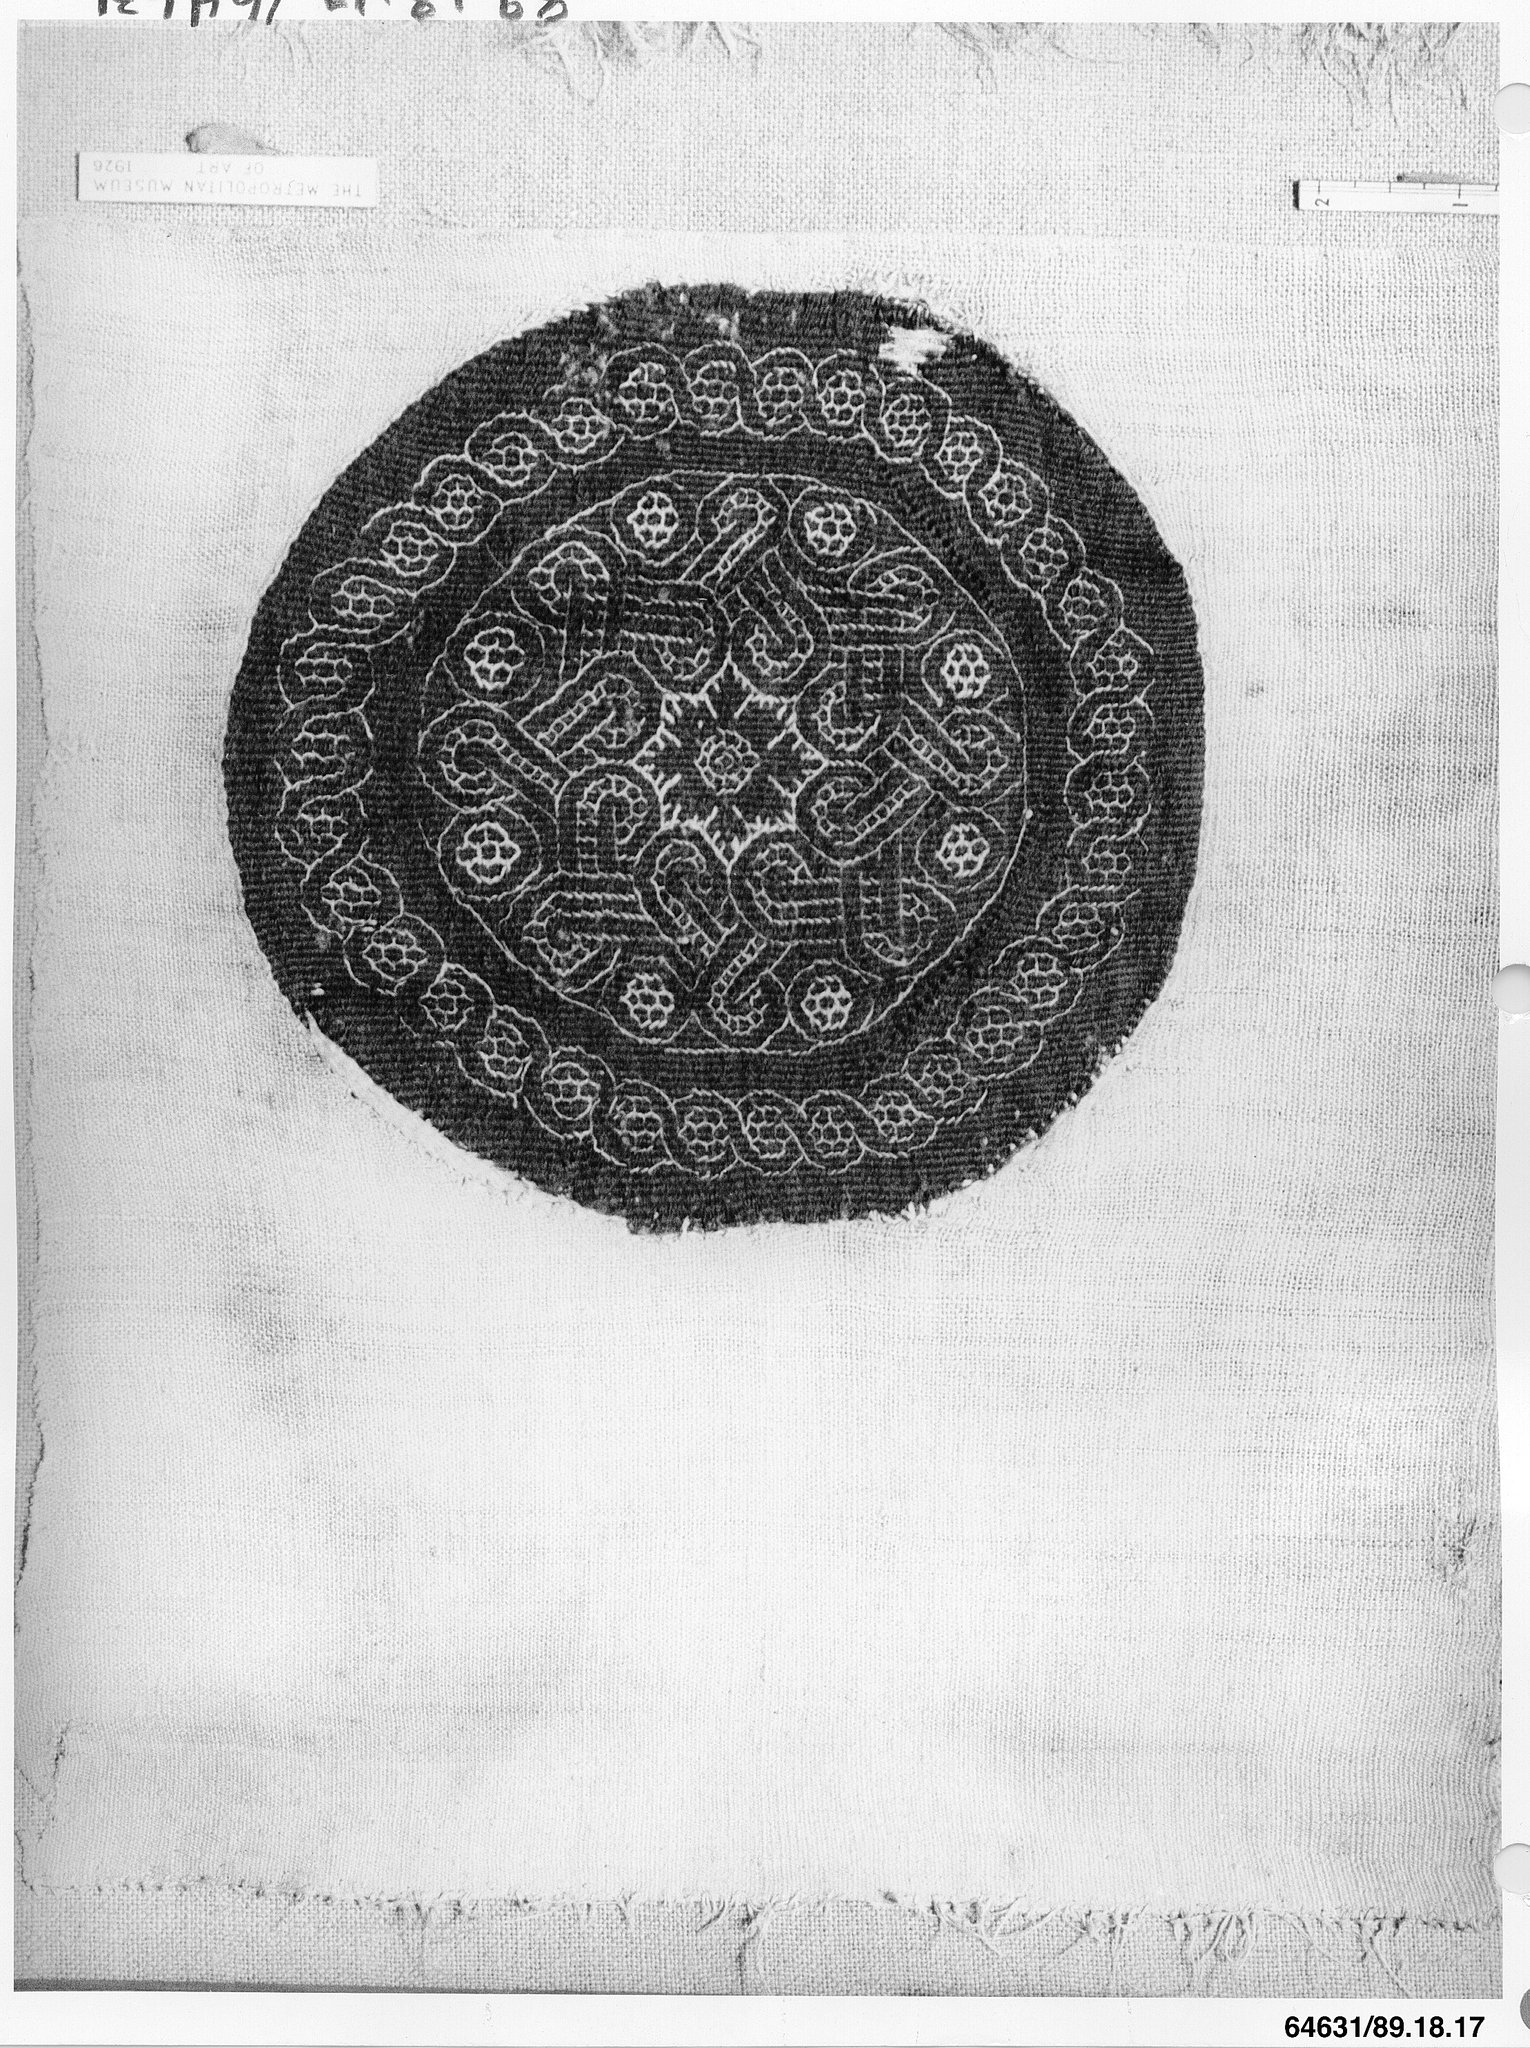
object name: textile fragment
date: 201-400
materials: linen, wool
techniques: weave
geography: egypt